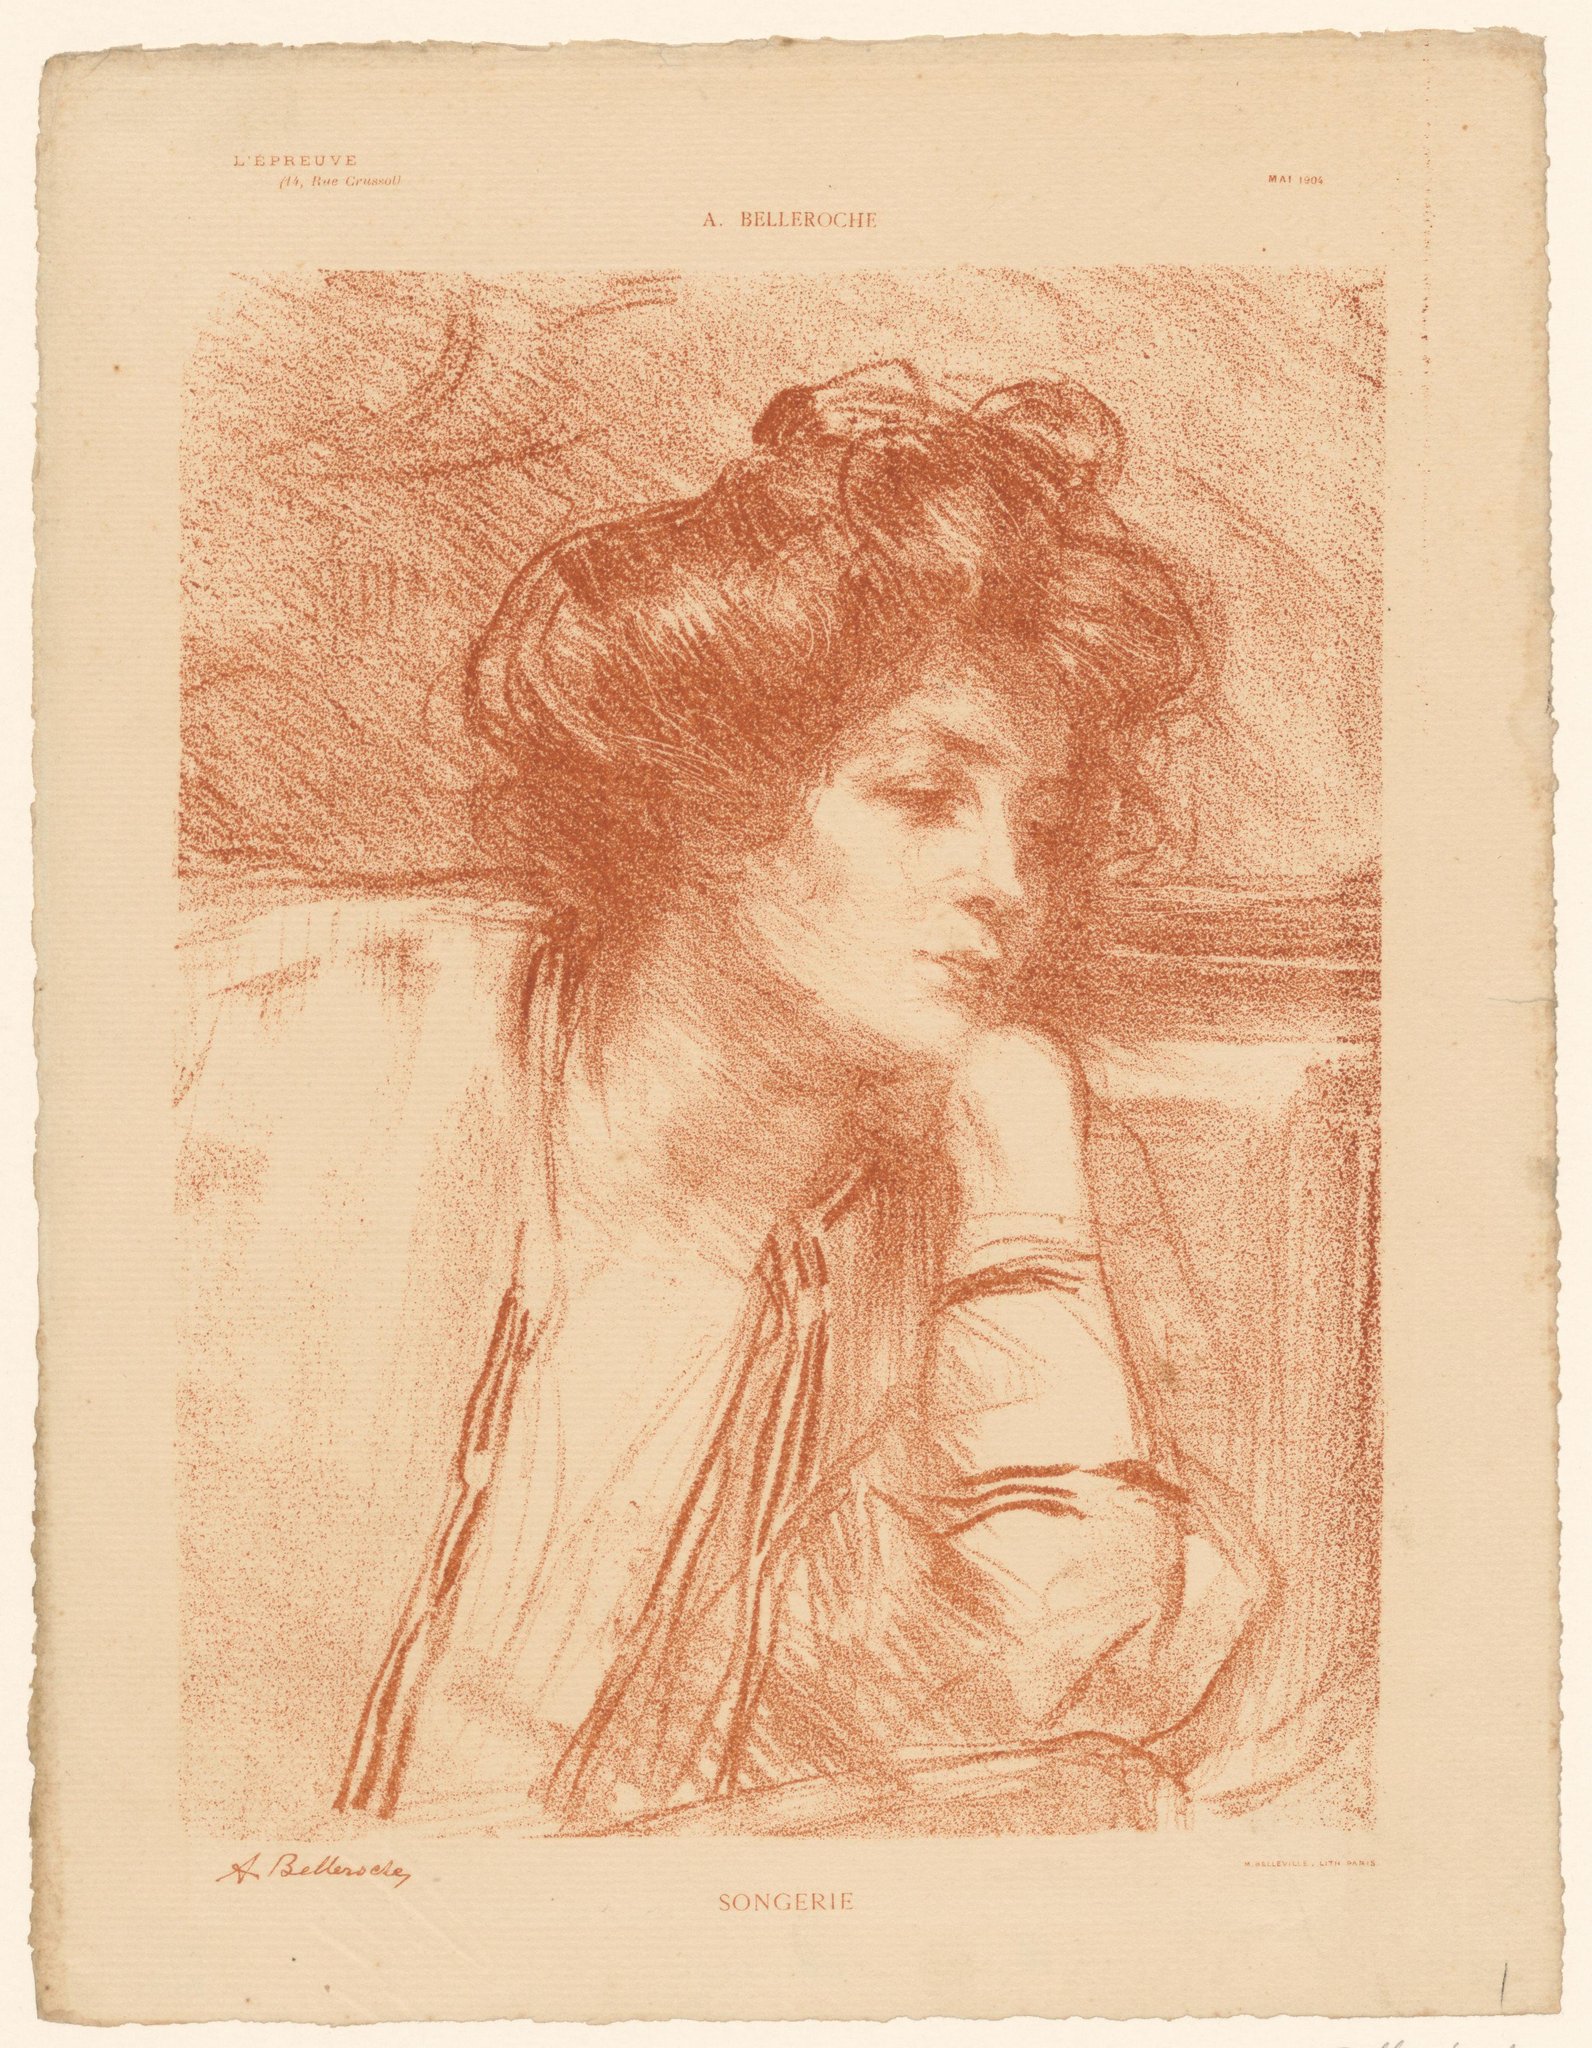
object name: print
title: Songerie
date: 1904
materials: paper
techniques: lithograph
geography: paris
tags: adult woman, dream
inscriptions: collector's mark: Lugt 2760, collector's mark: Lugt 2166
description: Linksboven: L'Epreuve (14, Rue Crussol).